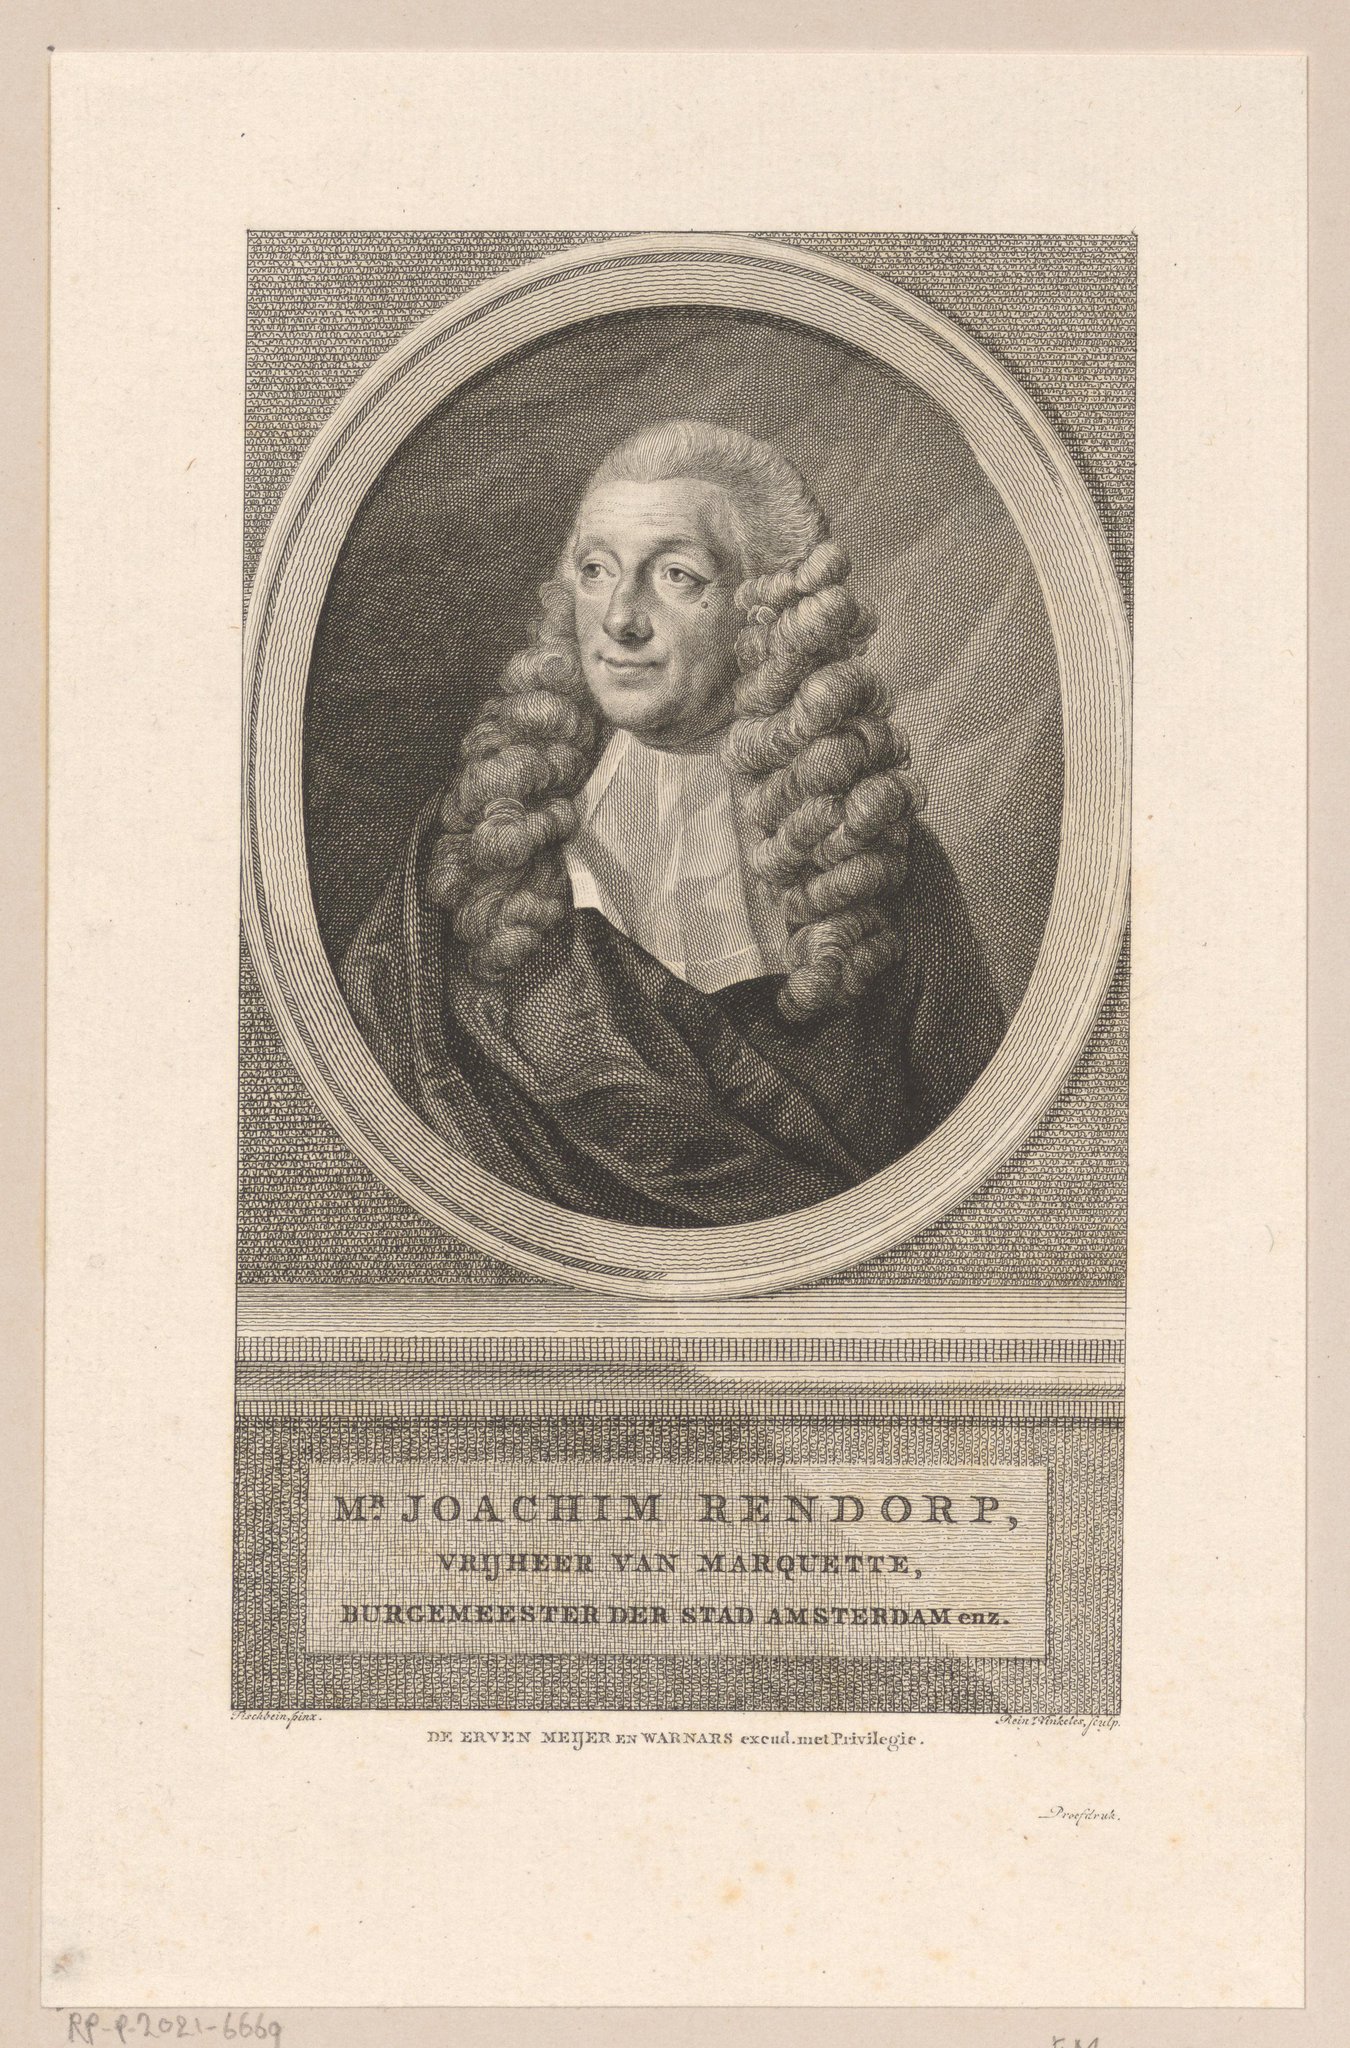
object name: print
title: Portret van Joachim Rendorp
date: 1781-1798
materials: paper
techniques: engraving, etching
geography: amsterdam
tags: joachim rendorp, historical persons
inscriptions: collector's mark: Lugt 240